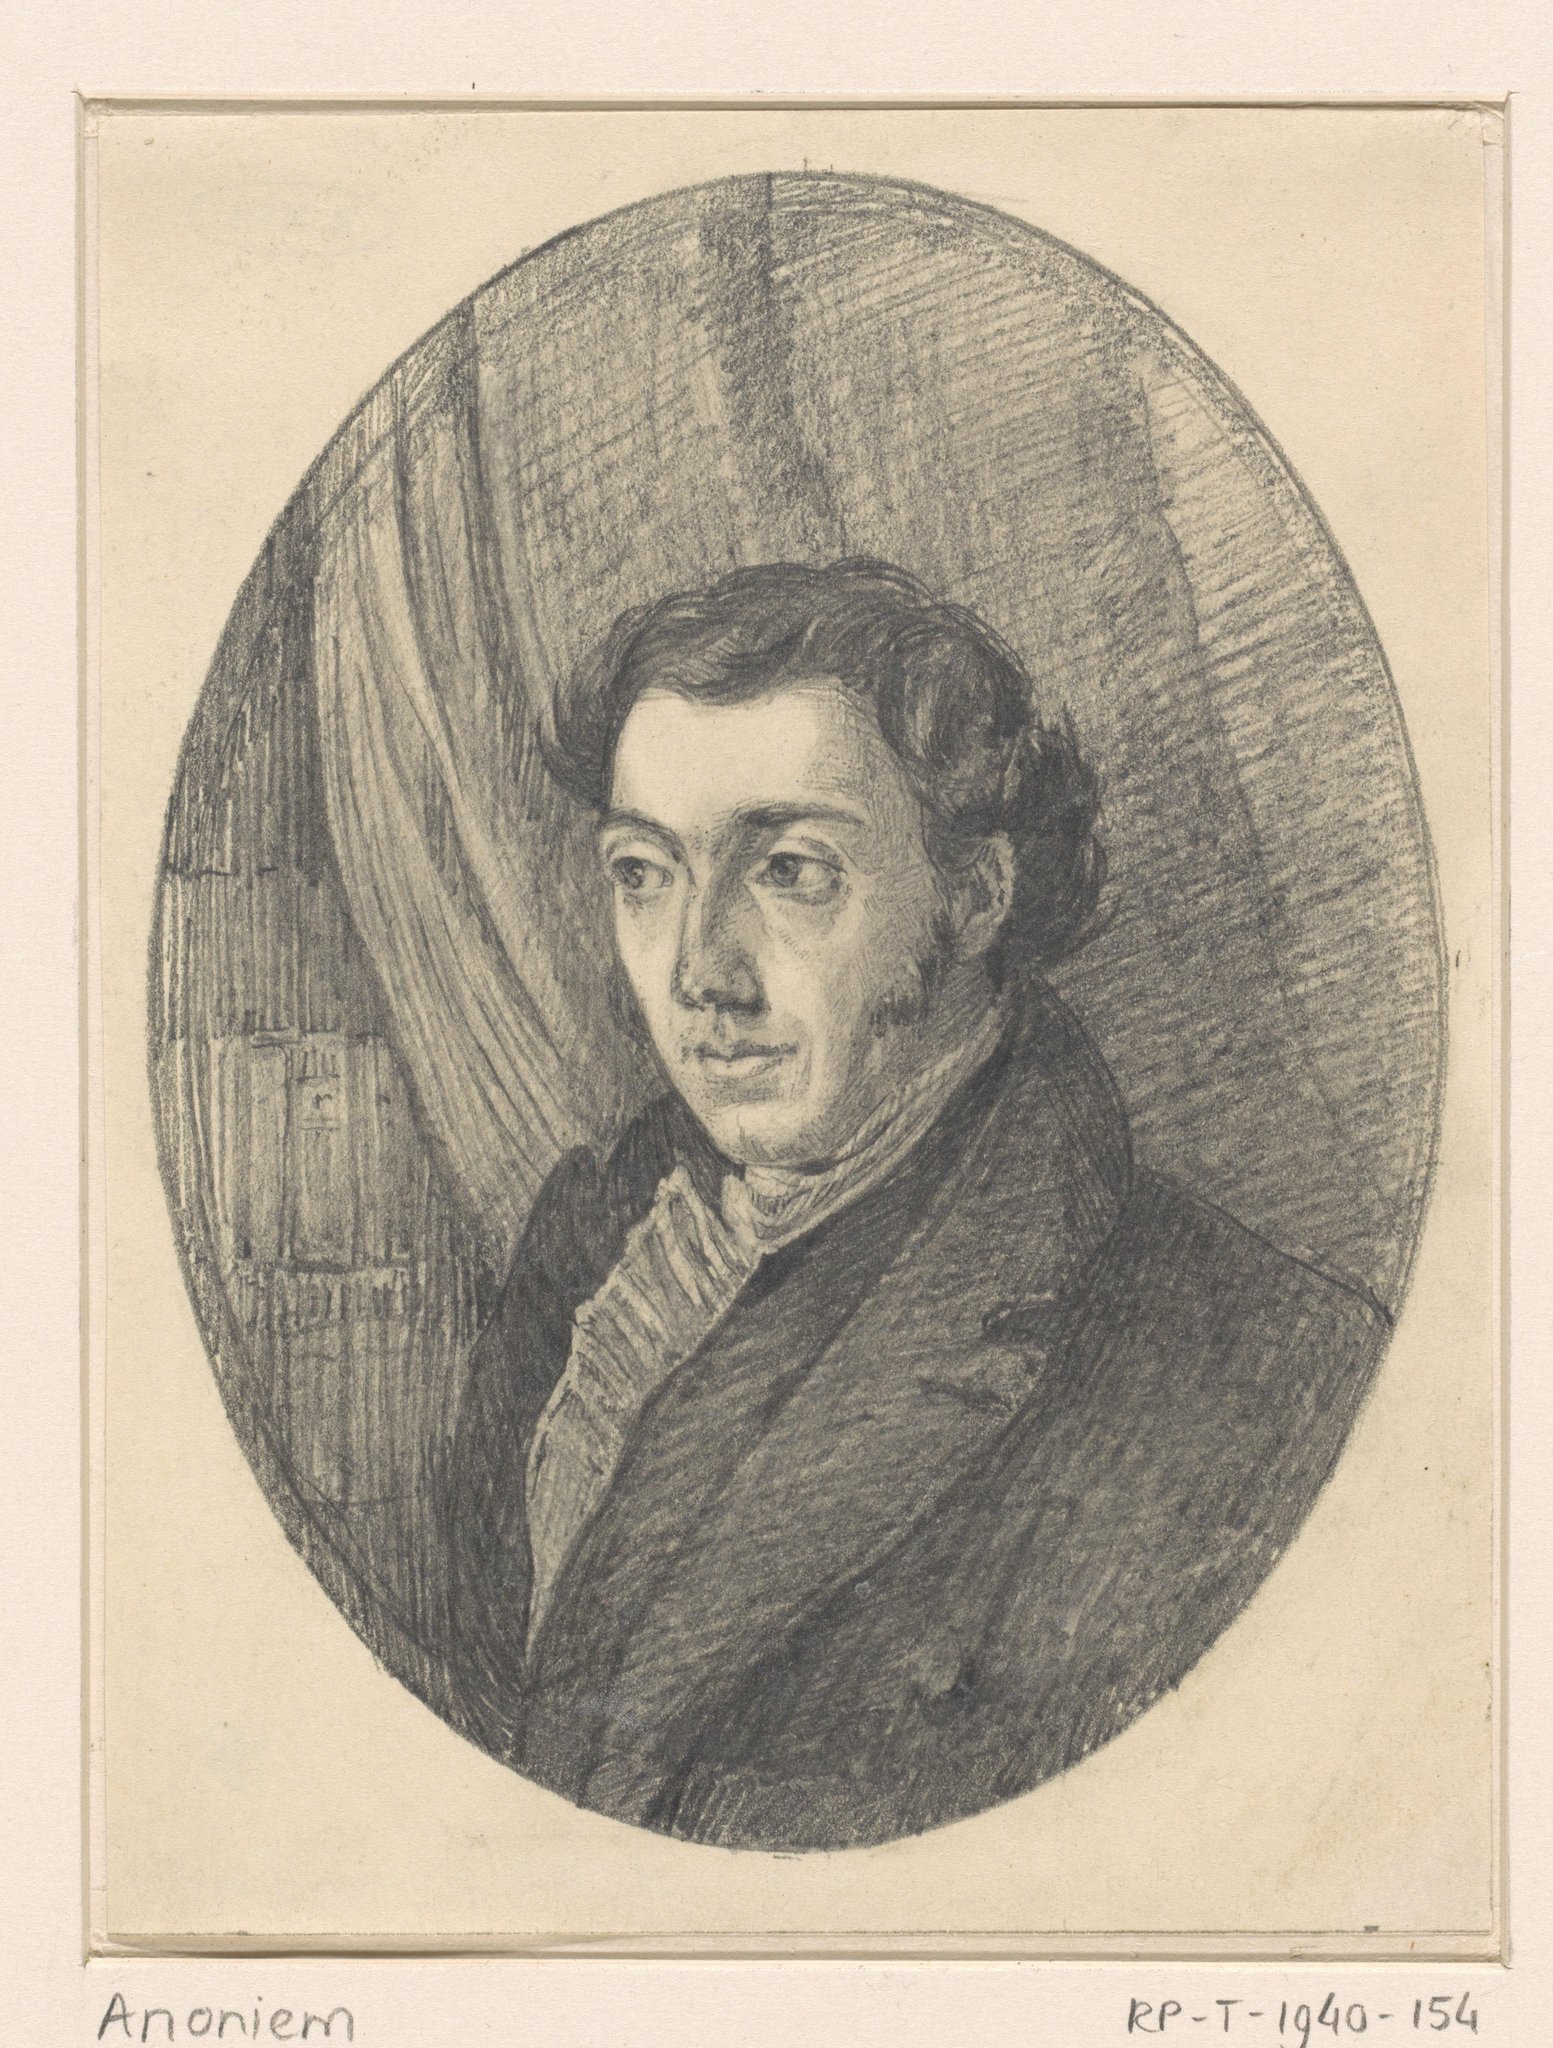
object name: drawing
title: Portret van J.P. Schonberg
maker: Anonymous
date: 1800-1900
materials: paper, pencil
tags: historical persons, portrait, self-portrait of artist